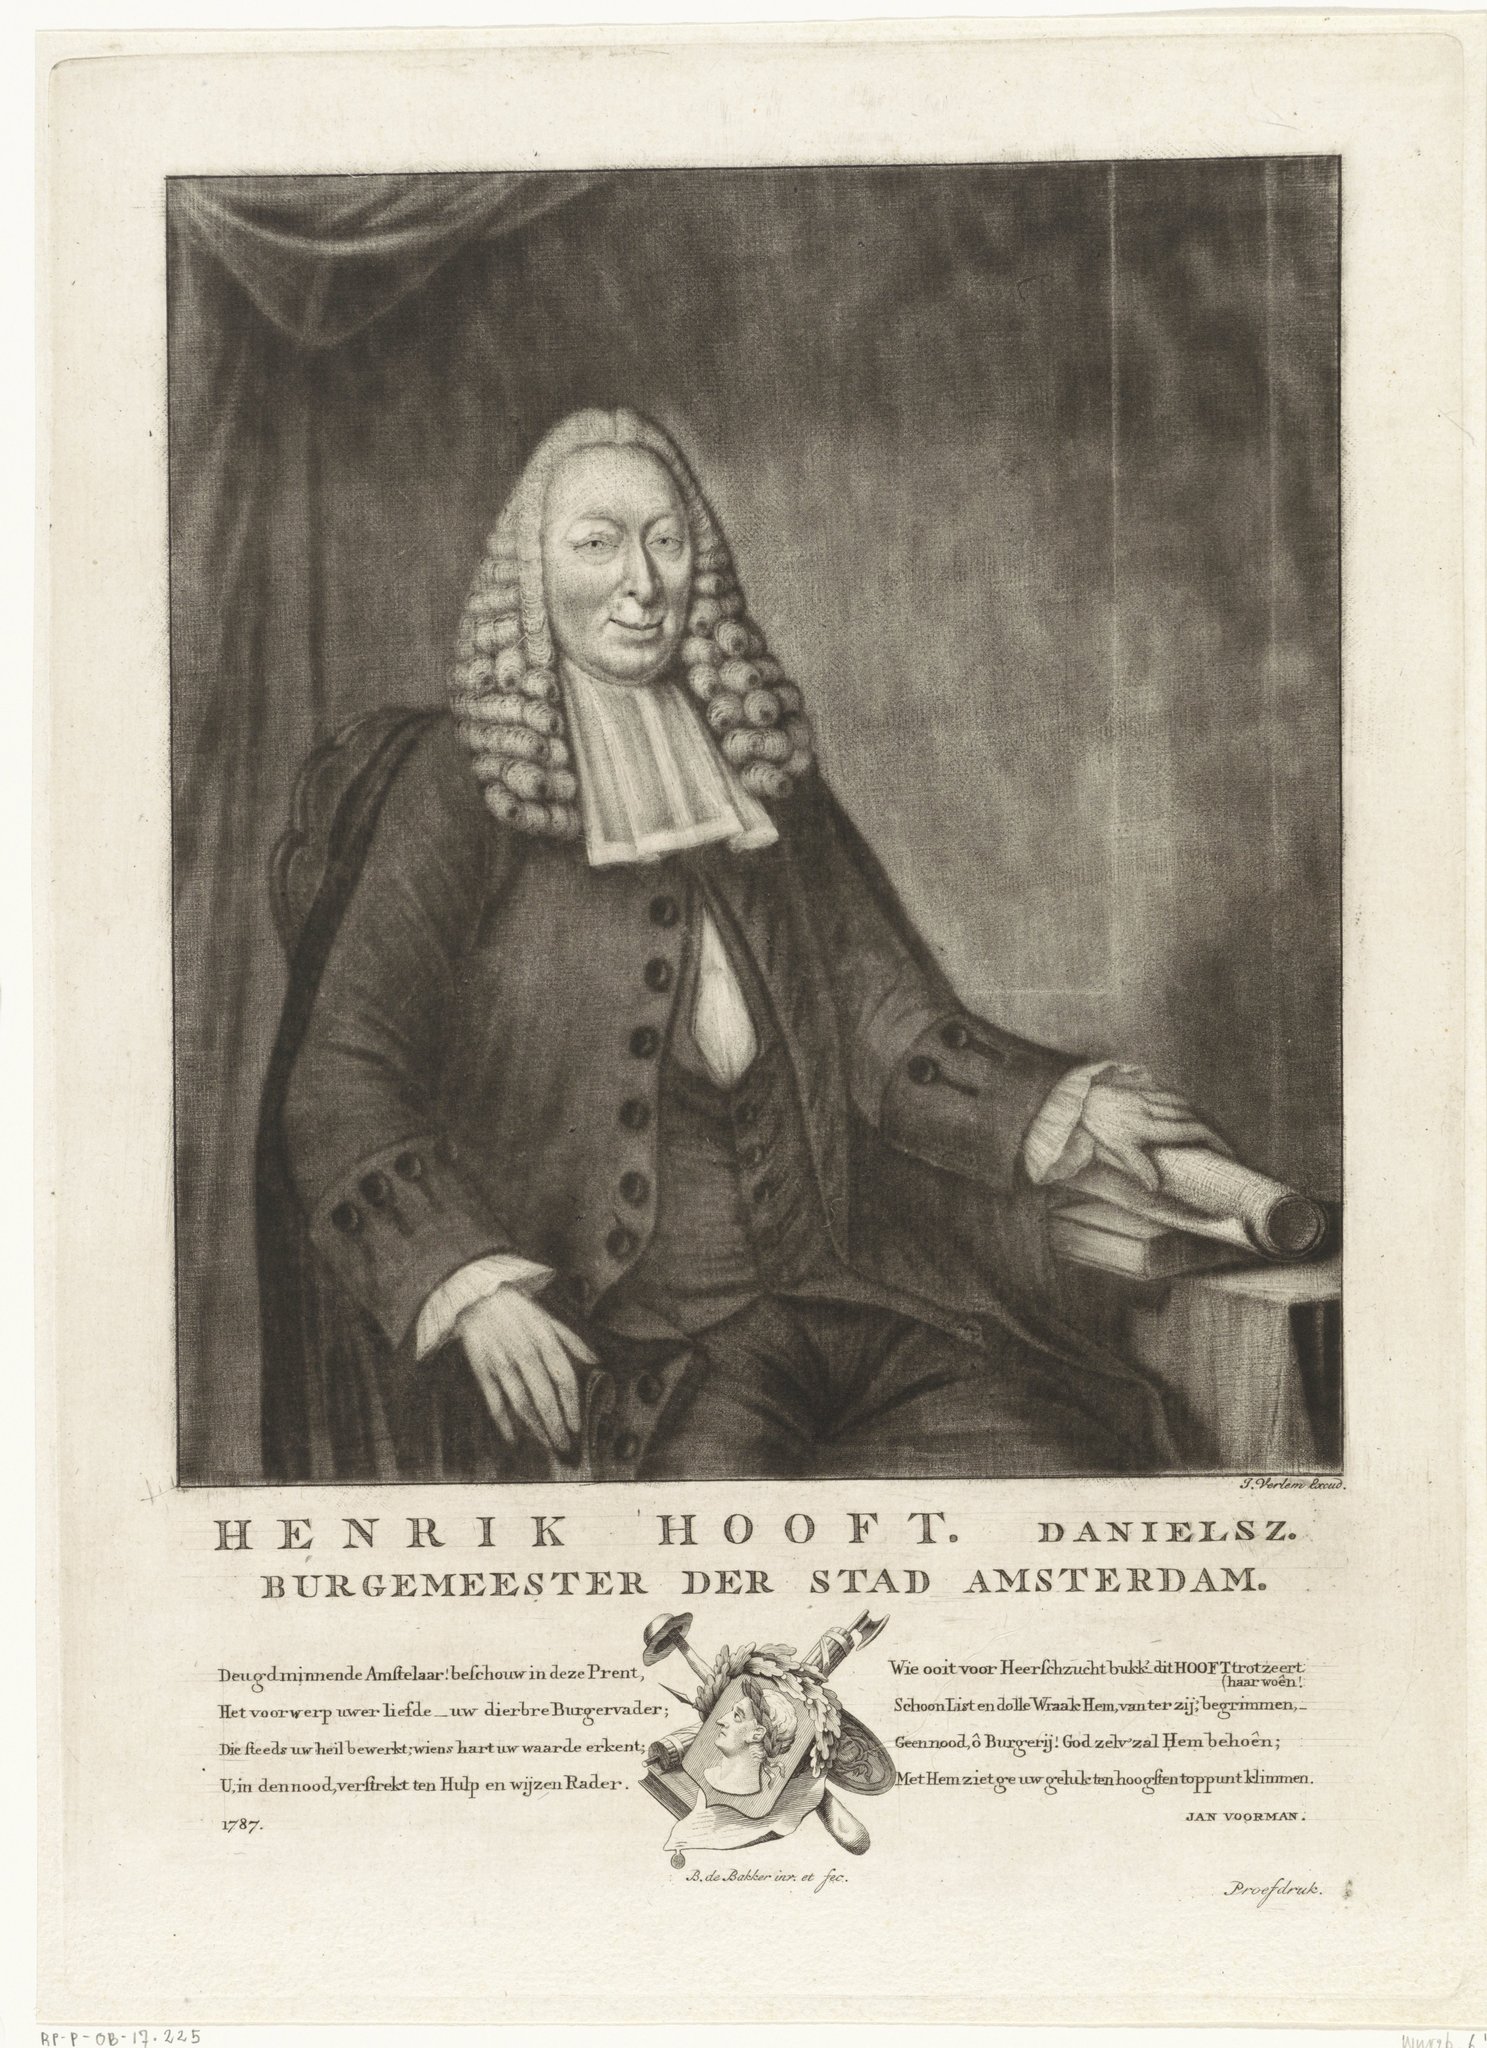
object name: print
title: Portret van Hendrik Danielsz. Hooft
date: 1787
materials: paper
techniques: engraving, etching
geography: amsterdam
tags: amsterdam, mayor, hendrik danielsz. hooft, book, wig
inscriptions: date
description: Hendrik Danielsz. Hooft, burgemeester van Amsterdam zit in een stoel en houdt een rol papier vast. Hij draagt een pruik en een brede bef. In de marge twee kolommen met tekst met daar tussen een met lauwerkrans gekroond wapen waaronder twee fasces, een vrijheidshoed en een schild.